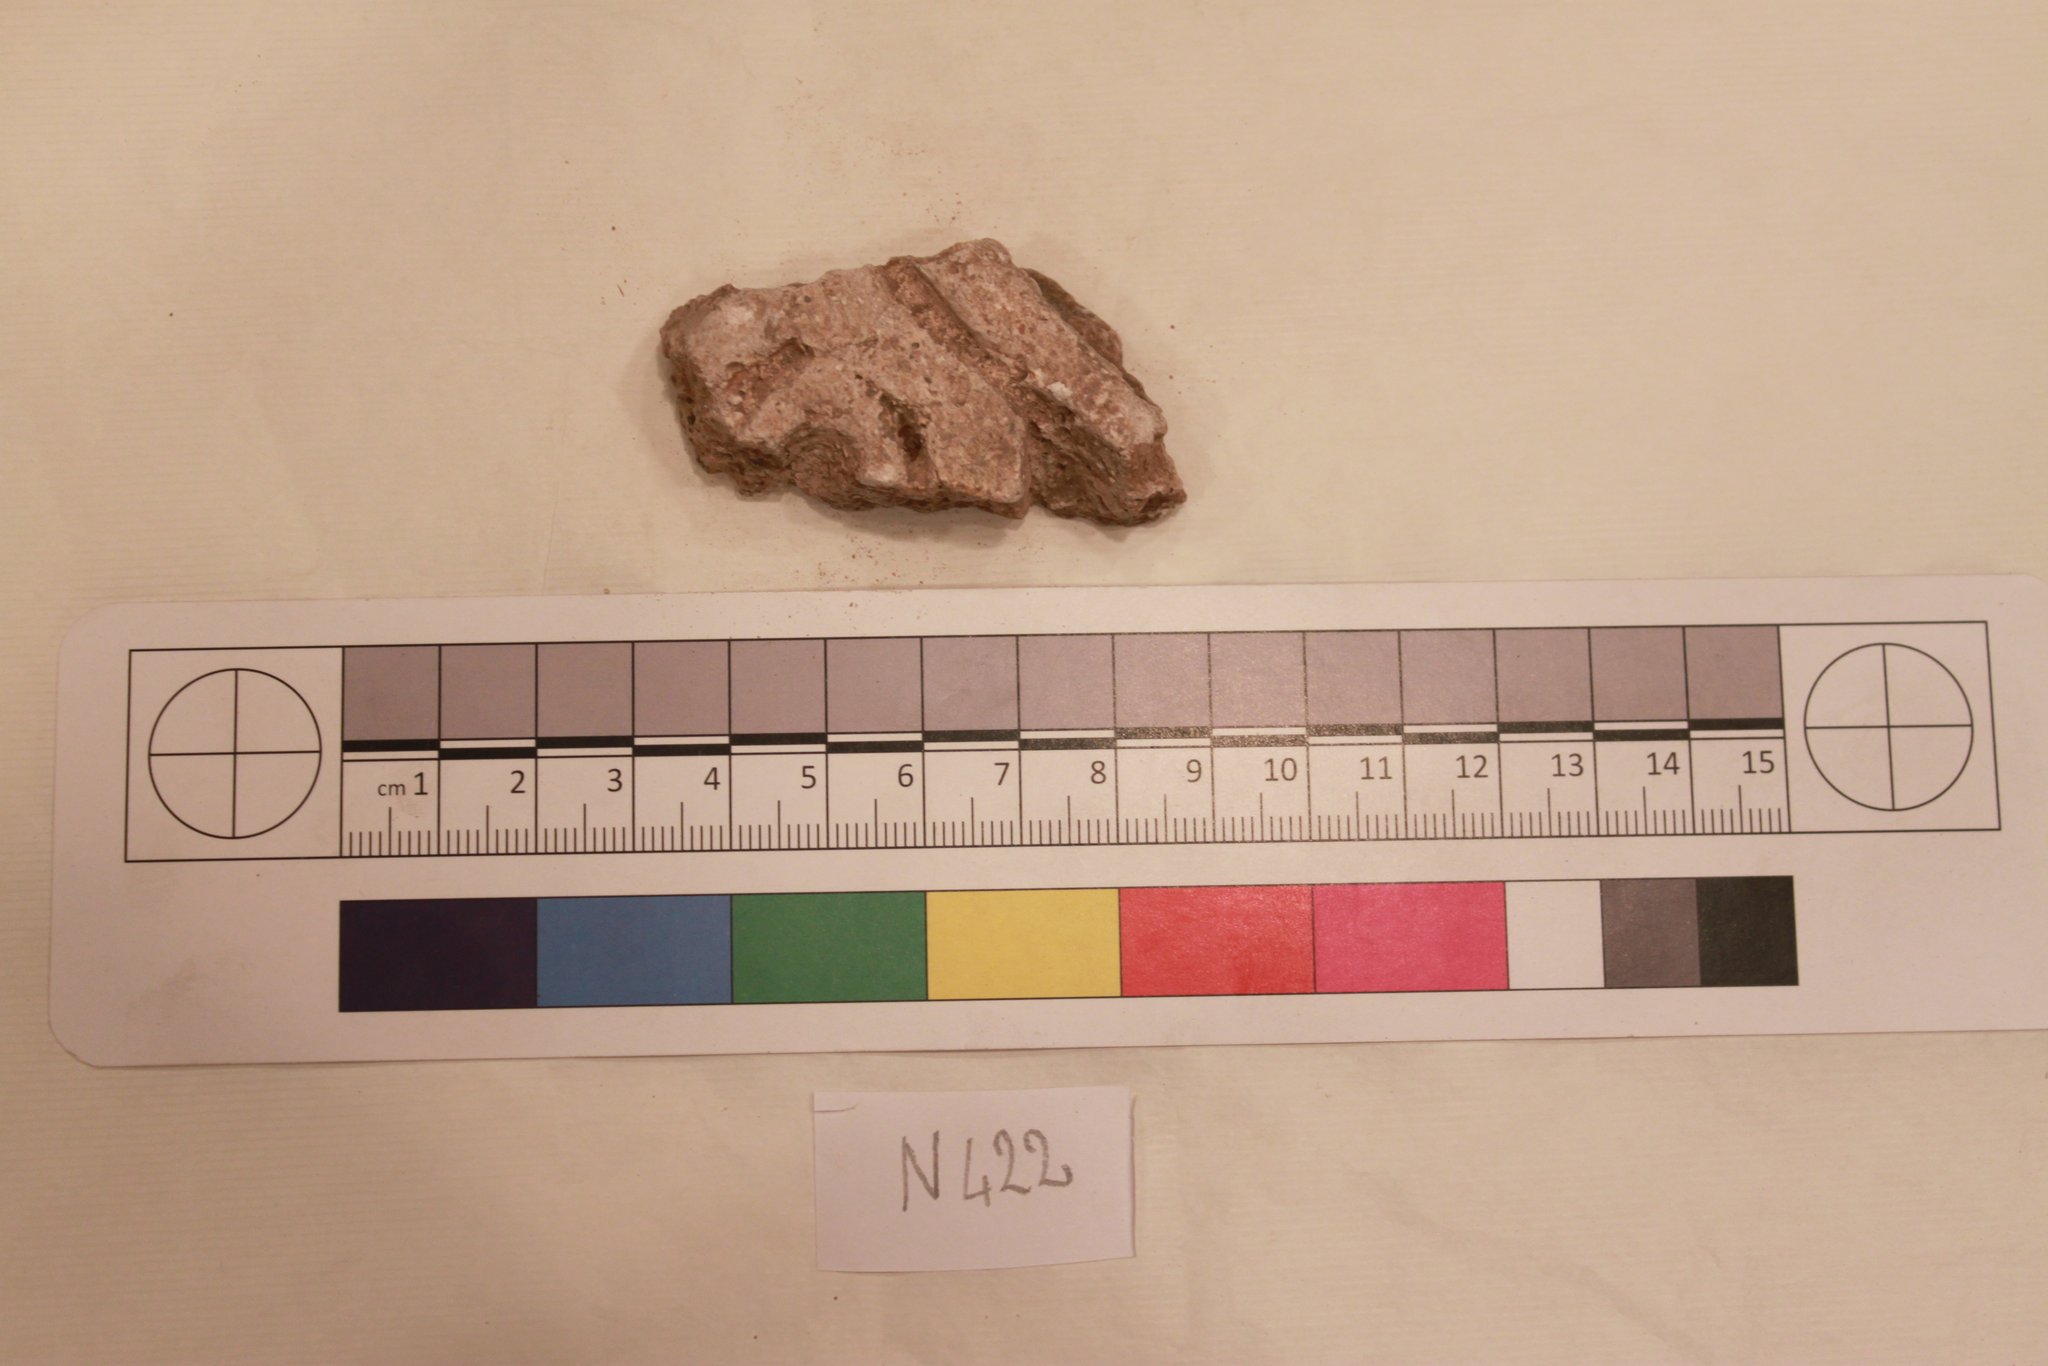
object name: fragment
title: Stucco Fragment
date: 701-1200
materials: plaster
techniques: carving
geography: iran